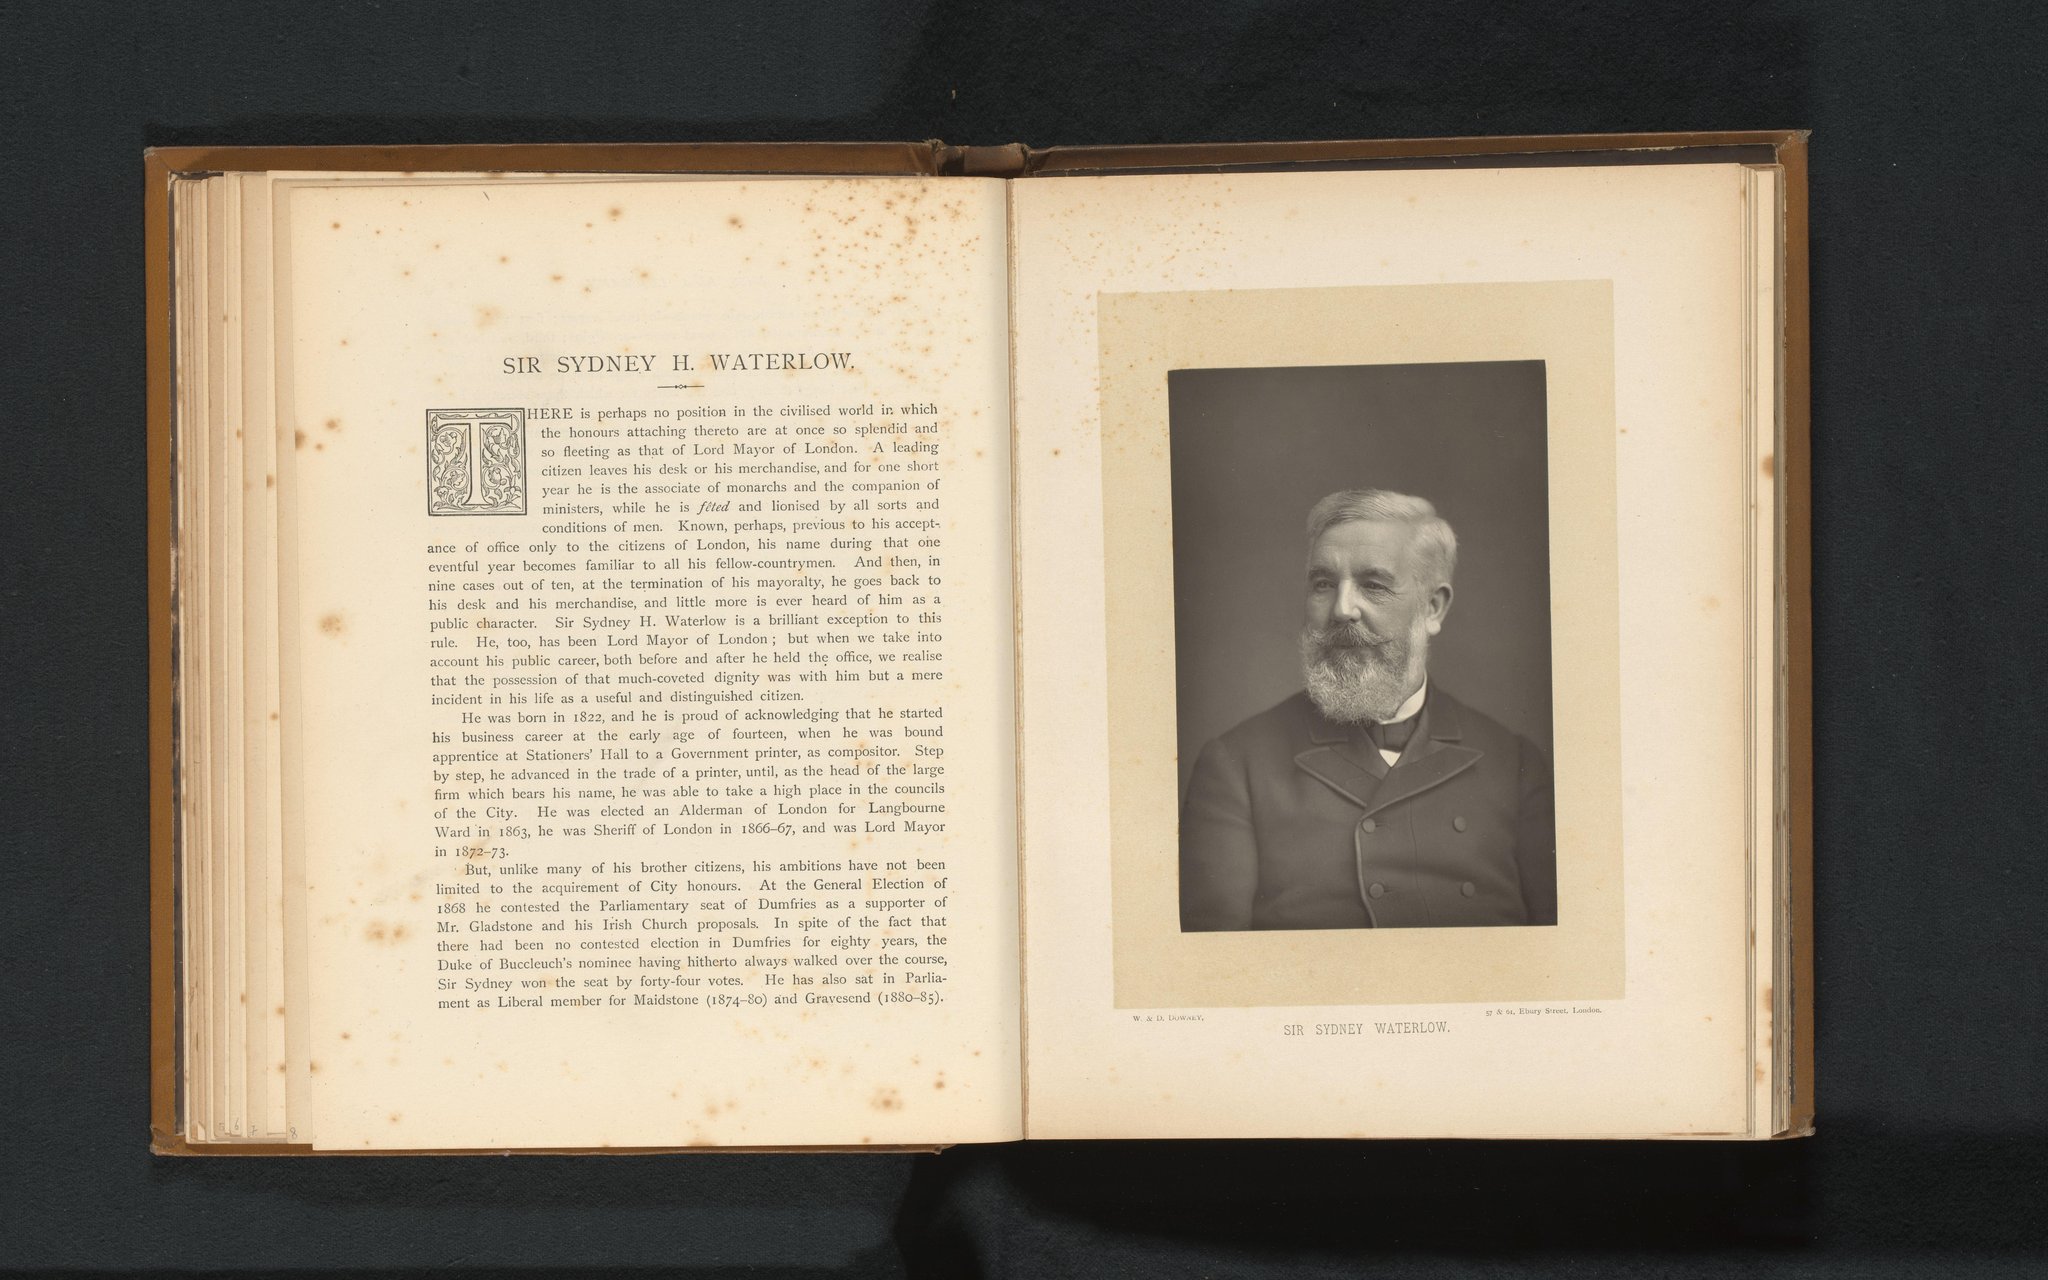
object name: page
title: Sir Sydney Waterlow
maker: Anonymous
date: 1882-1892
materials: paper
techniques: woodburytype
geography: london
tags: politician, philantropist, politician, e.g. party leader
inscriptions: inscription: ‘57 & 61, Elbury Street, London.’